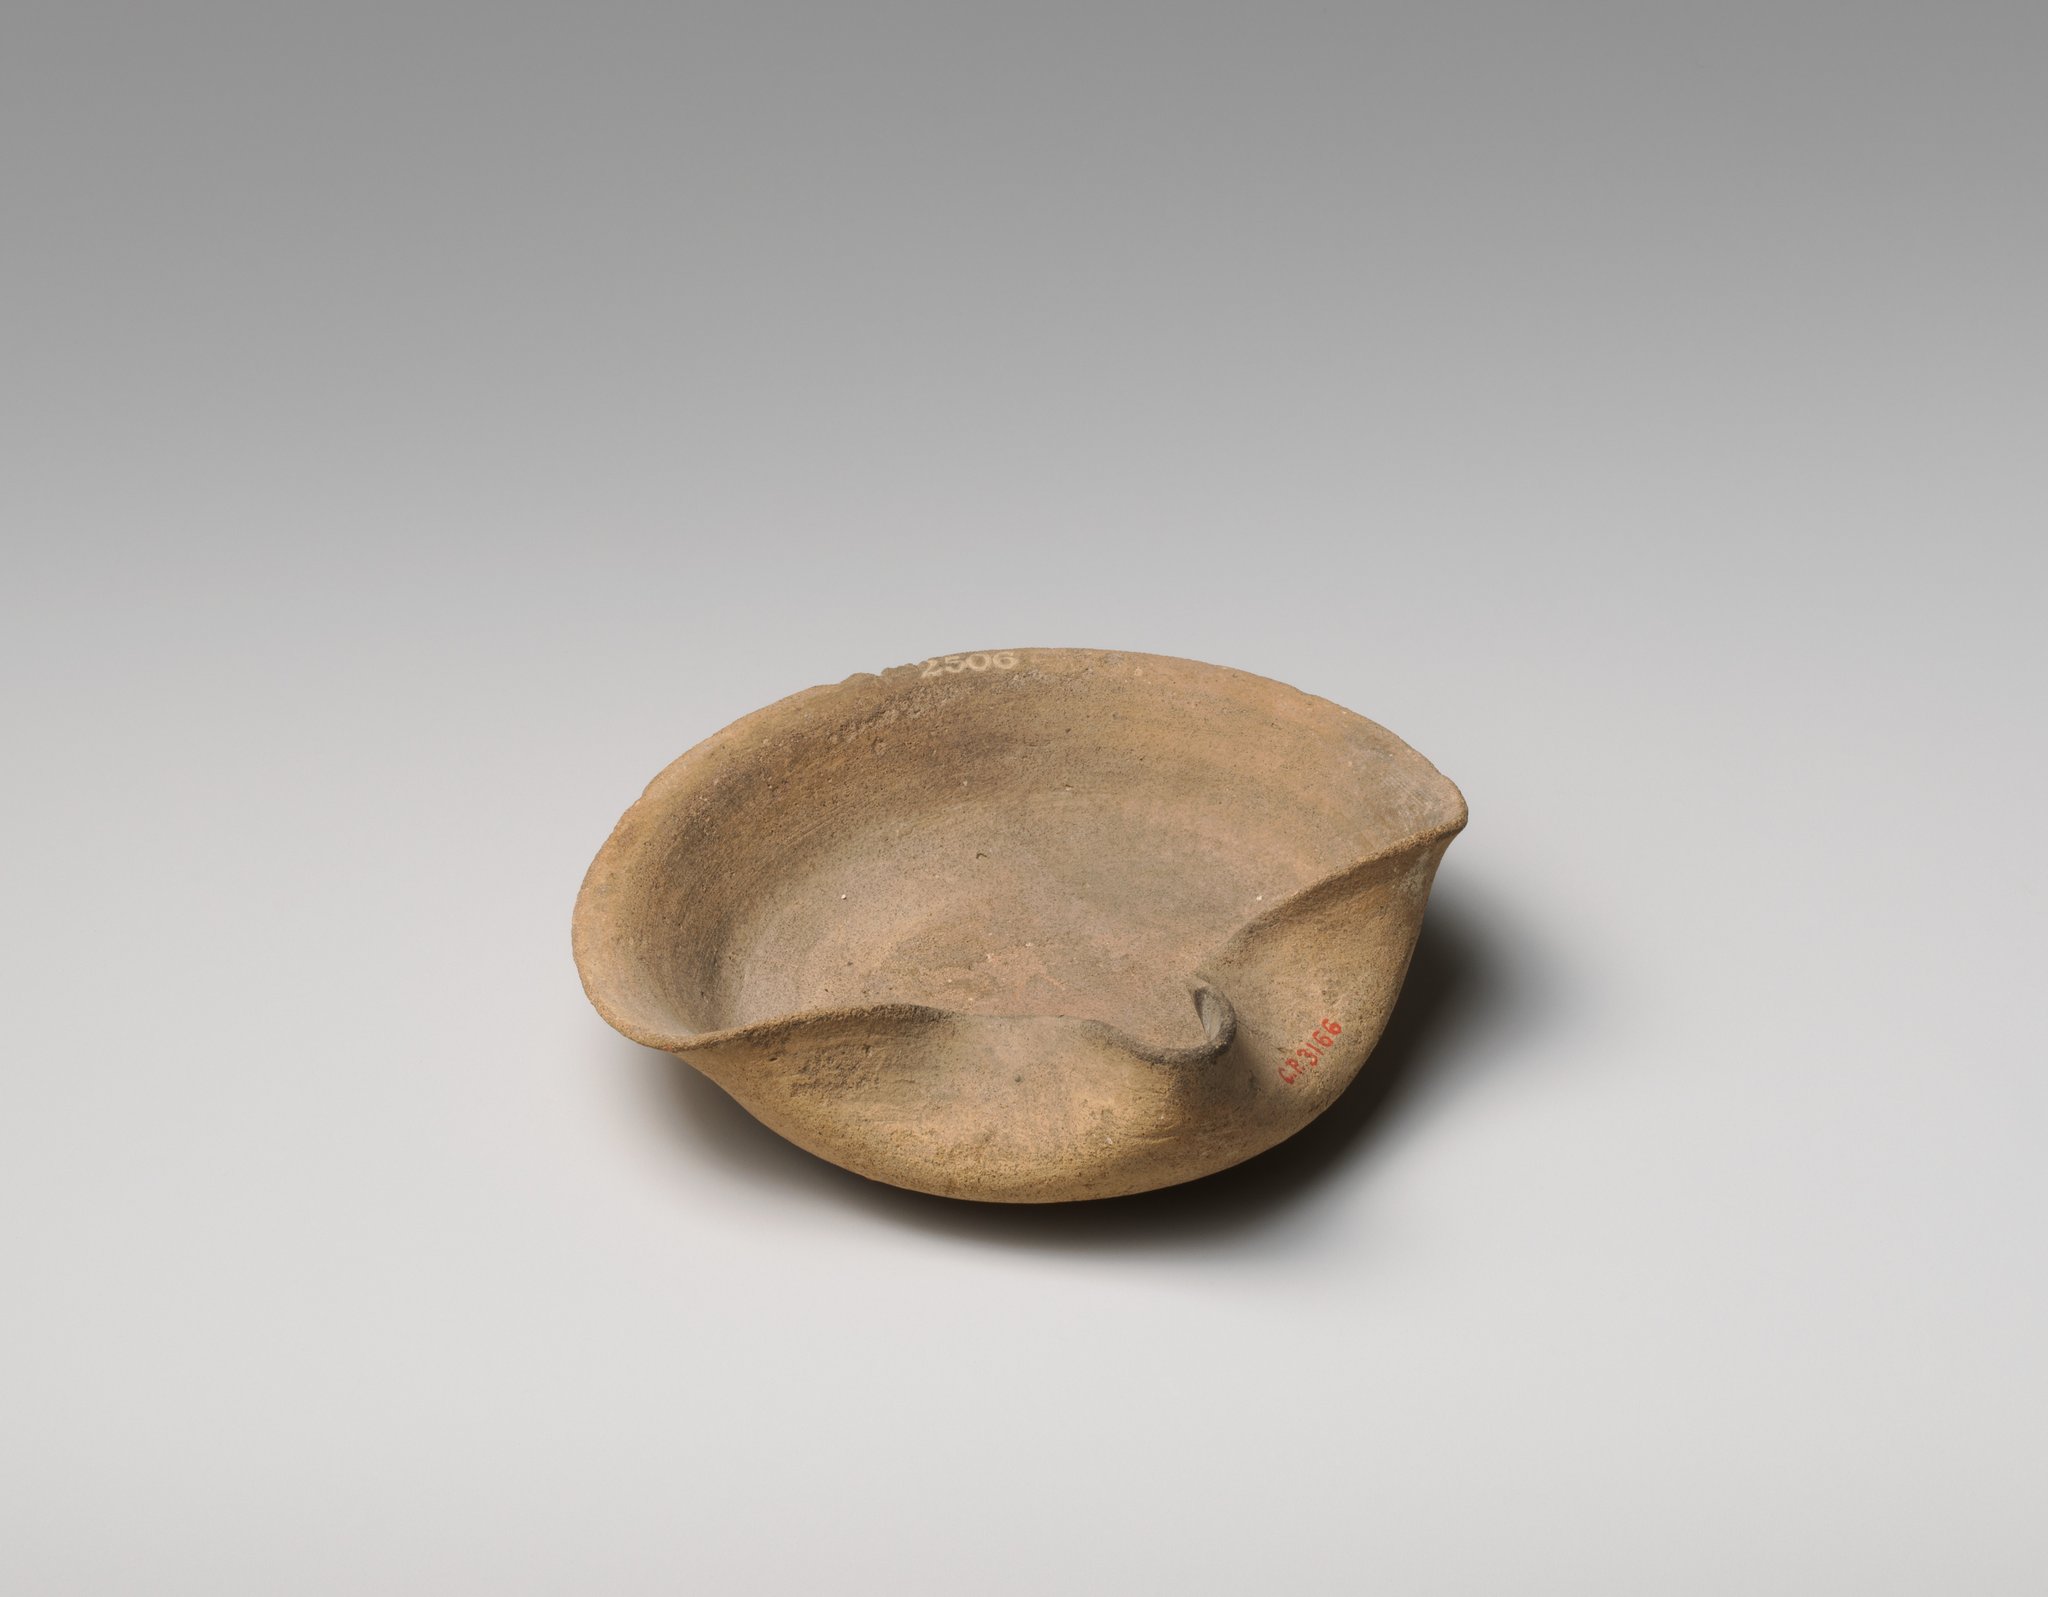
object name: lamp, saucer shaped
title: Terracotta saucer-shaped lamp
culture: cypriot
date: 400-301 BCE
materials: terracotta